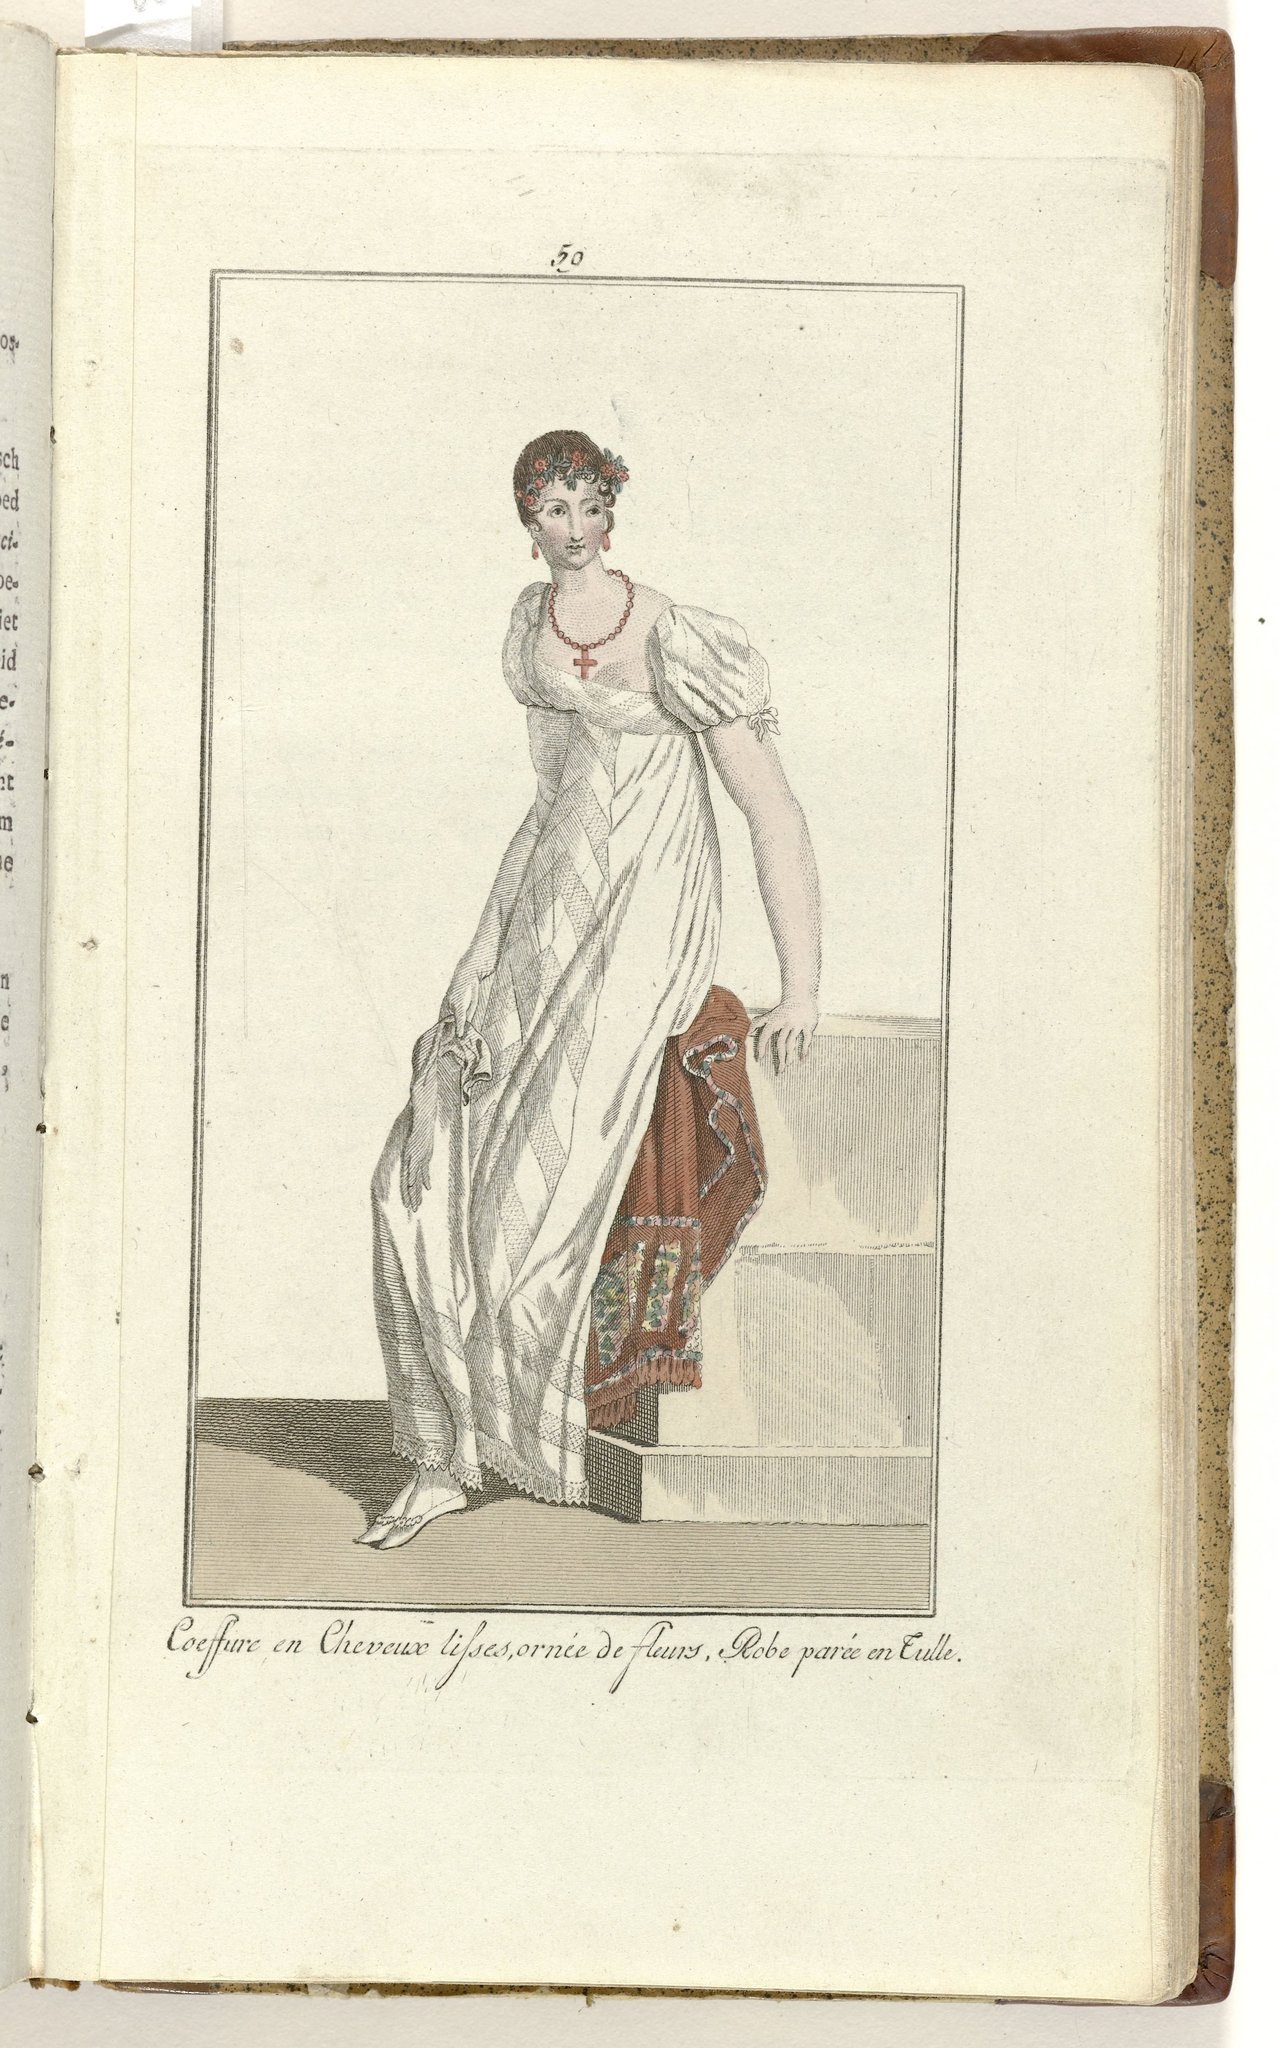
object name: magazine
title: Elegantia, of tijdschrift van mode, luxe en smaak voor dames, Oktober 1808, No. 59: Coeffure en Cheveux lisses...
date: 1808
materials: paper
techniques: engraving, hand coloring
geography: amsterdam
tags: flowers, ear-rings (+ women's clothes), pendant, trinket, 'breloque' (+ women's clothes), gloves, mittens (long gloves) (+ women's clothes), clothing for the upper part of the body (shawl) (+ women's clothes), styles of hairdress - aa - ~ women, fashion plates, dress, gown (+ women's clothes)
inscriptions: caption: ‘Coeffure en Cheveux lisses, ornée de fleurs, Robe parée en Tulle.’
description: Volgens de begeleidende tekst (p. 320): Geklede japon gegarneerd met tule. Kapsel met bloemen doorvlochten. Collier en oorringen van koraal. Prent uit het modetijdschrift Elegantia, of tijdschrift van mode, luxe en smaak voor dames 1807-1814 (onderbroken door de periode 1811-1813).